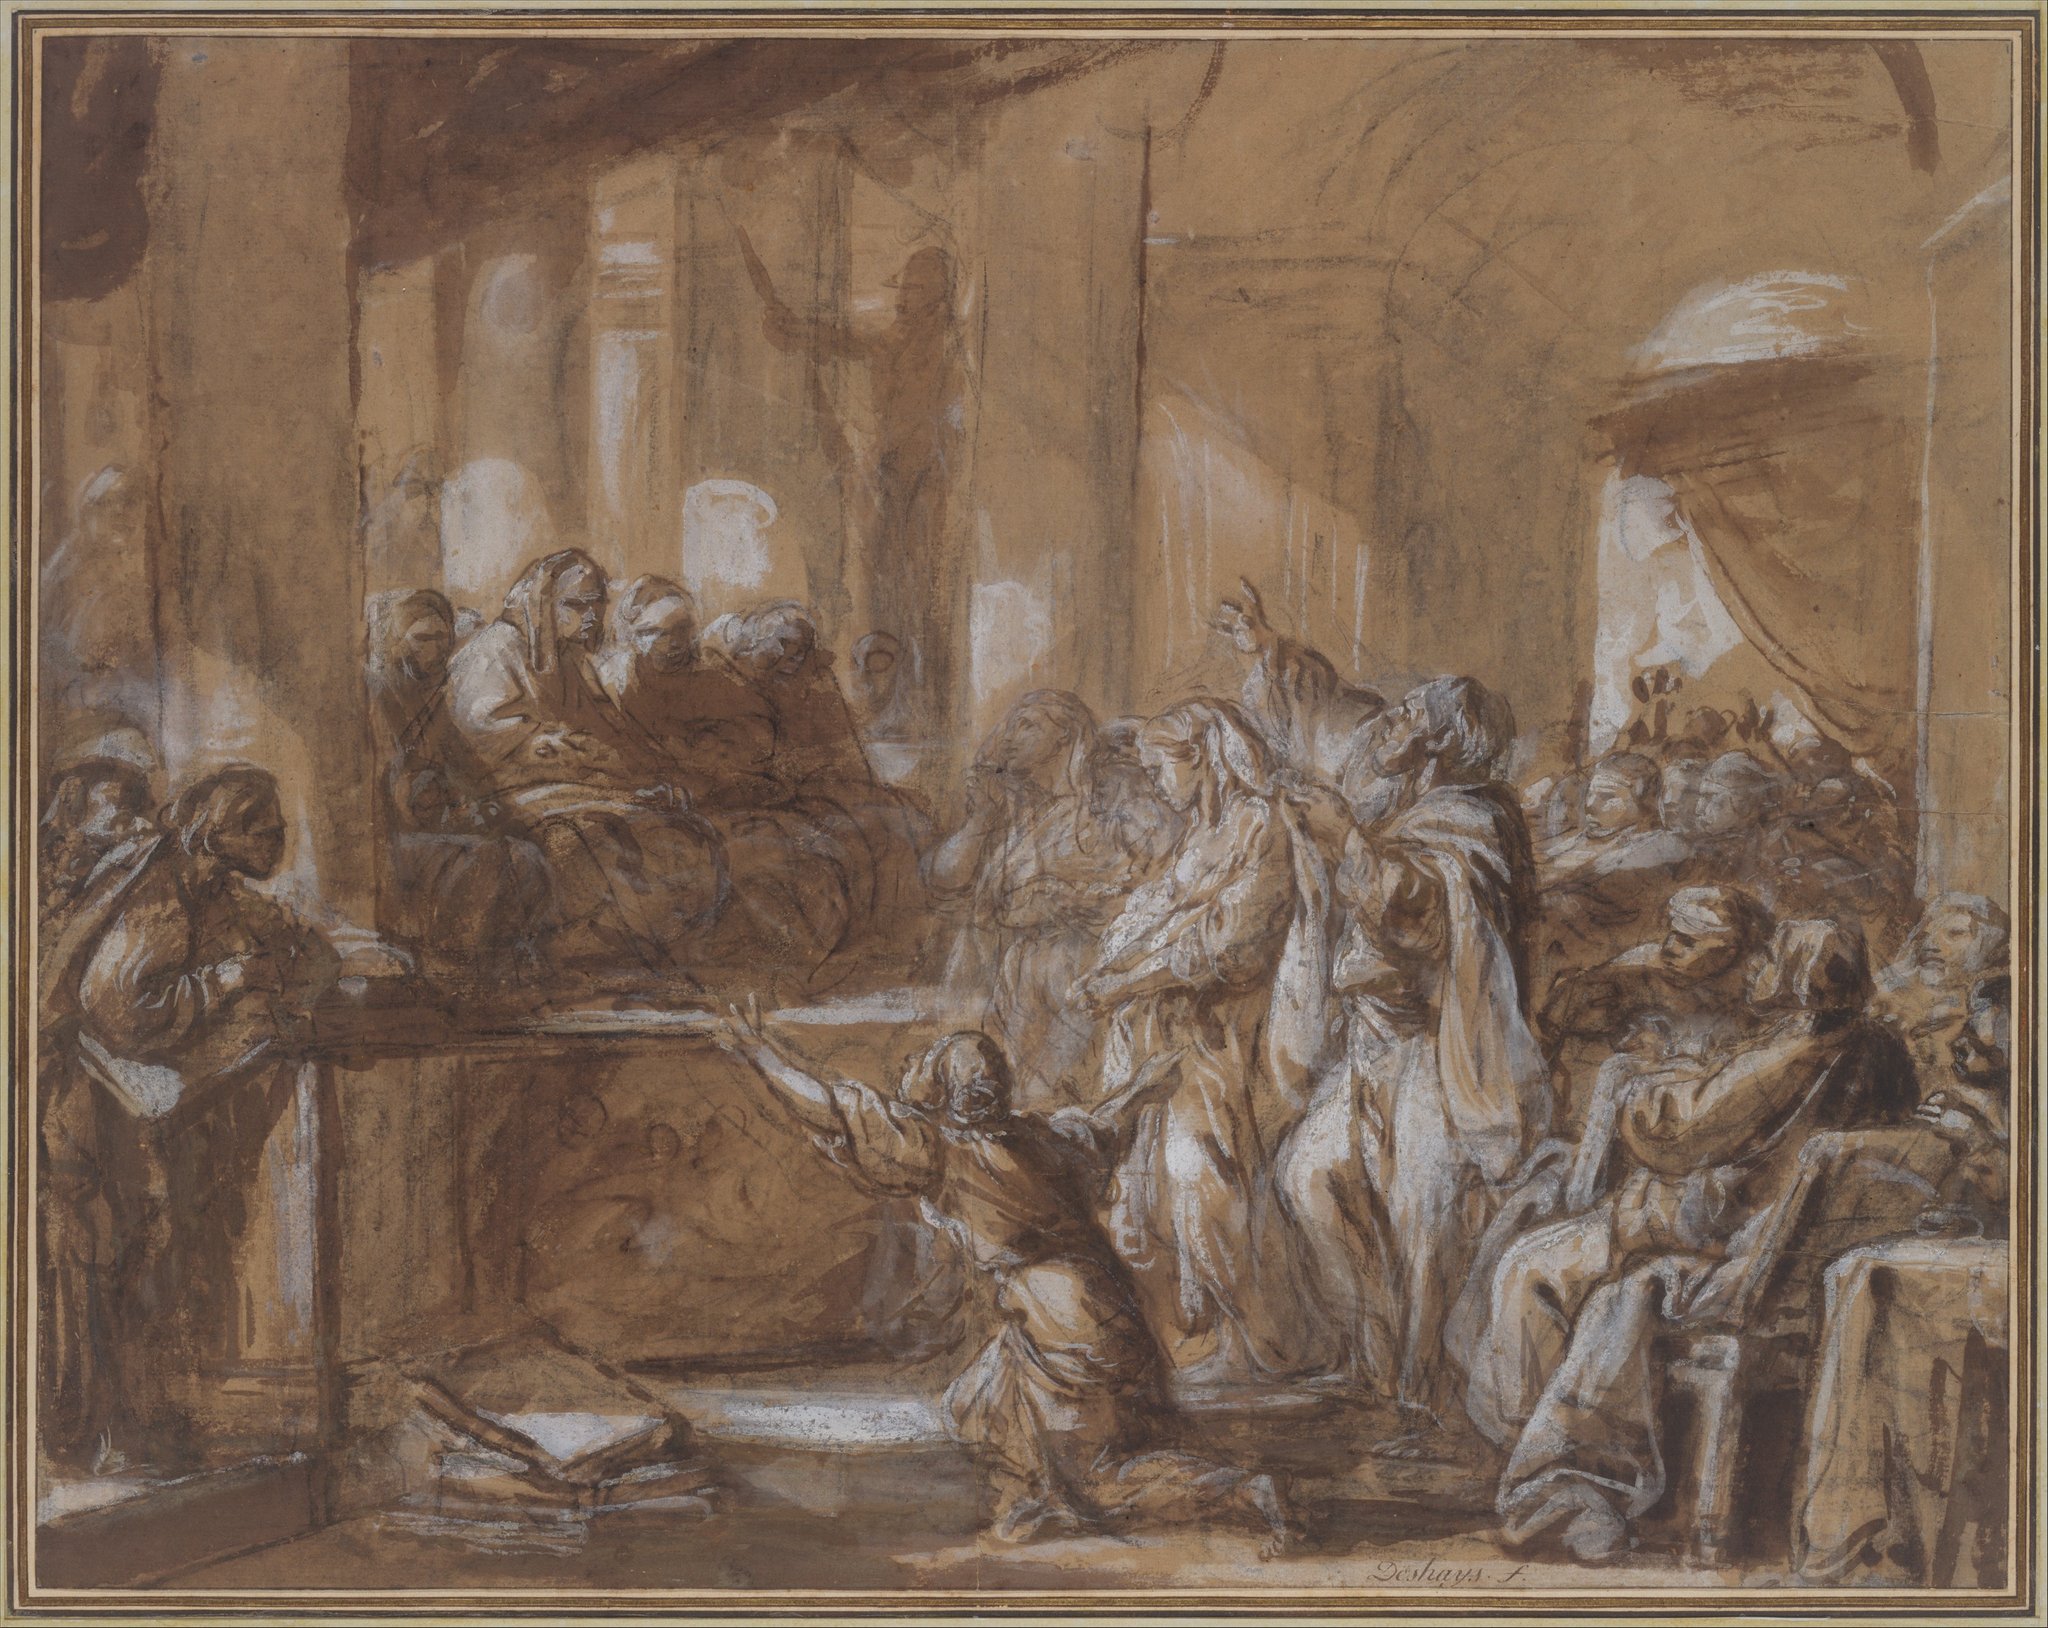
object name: drawing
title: Phryne Before the Areopagus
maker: jean-baptiste deshays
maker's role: artist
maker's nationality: french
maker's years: 1729-1765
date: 1734-1766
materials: chalk, ink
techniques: heightening, pen, wash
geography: france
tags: crowd